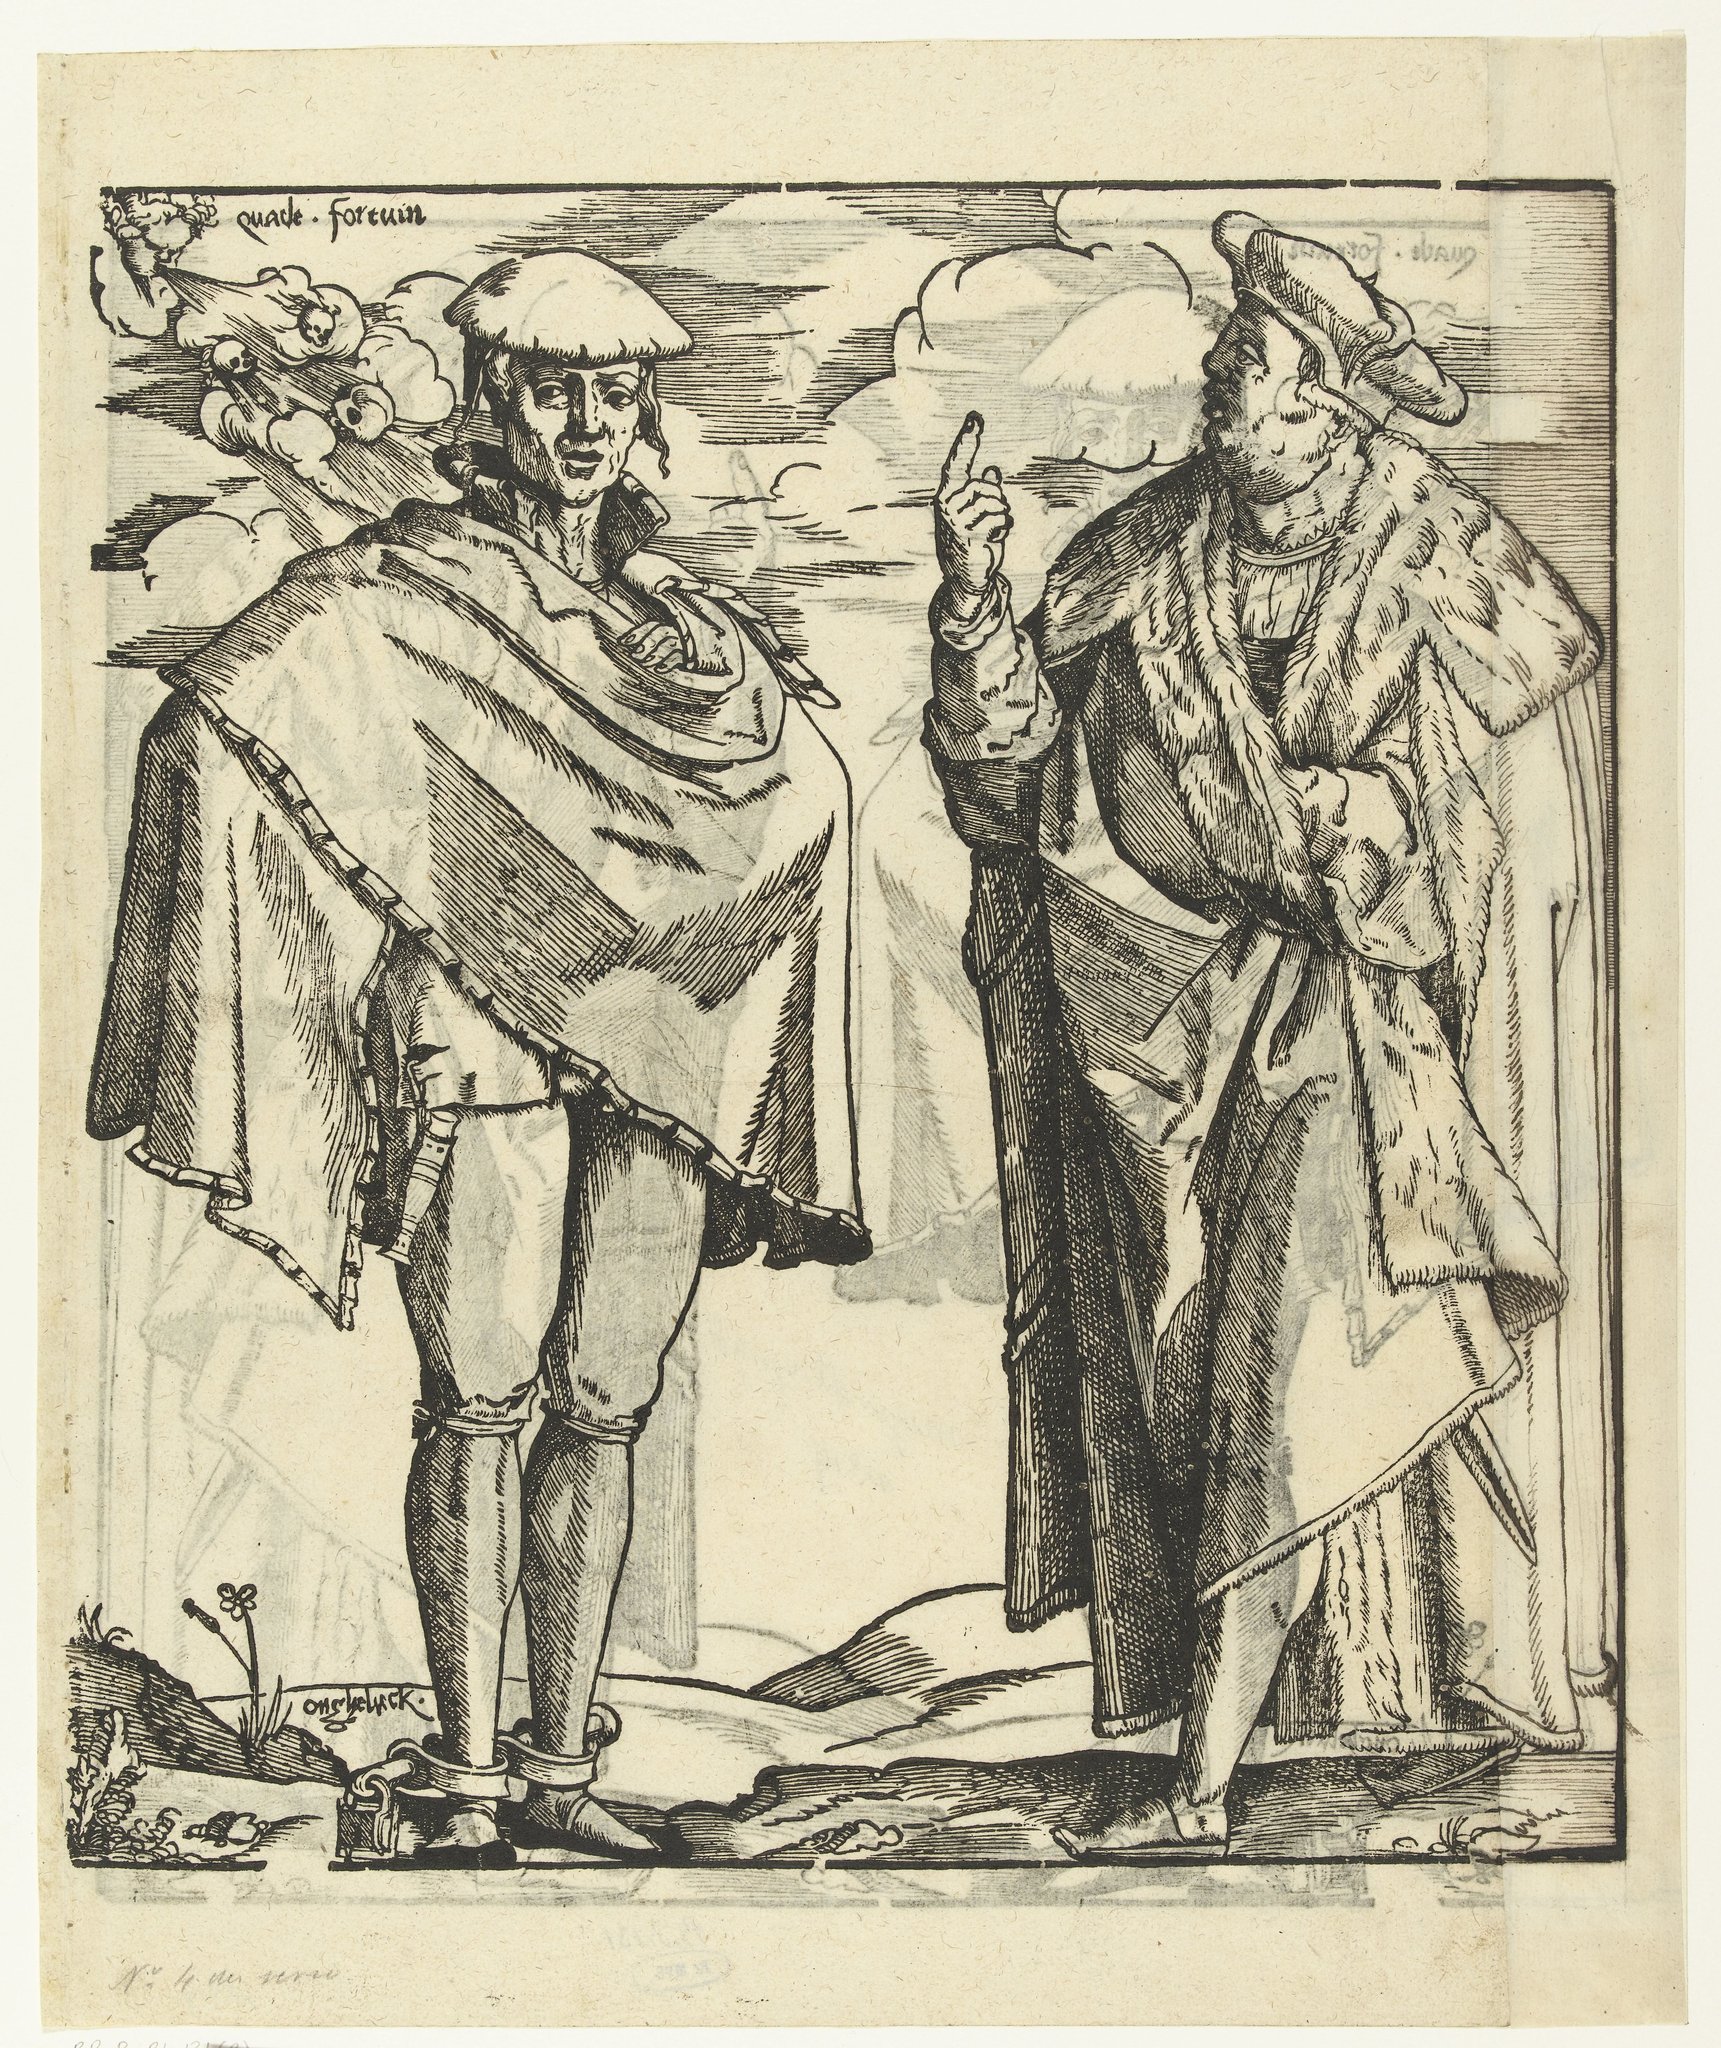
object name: print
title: De lichtzinnige jeugd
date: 1542-1546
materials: paper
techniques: woodcut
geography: amsterdam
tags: adversity, misfortune, bad luck; 'fortuna infelice', 'infortunio' (ripa), youth, adolescent, (person) in fetters, not imprisoned, frivolity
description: Vierde blok, onderdeel van een fries van vier blokken. Jongeman geketend door "ongeluck", en "quade fortuin" wordt hem toegeblazen. Naast hem een raadsheer als vertegenwoordiger van de aardse gerechtigheid.